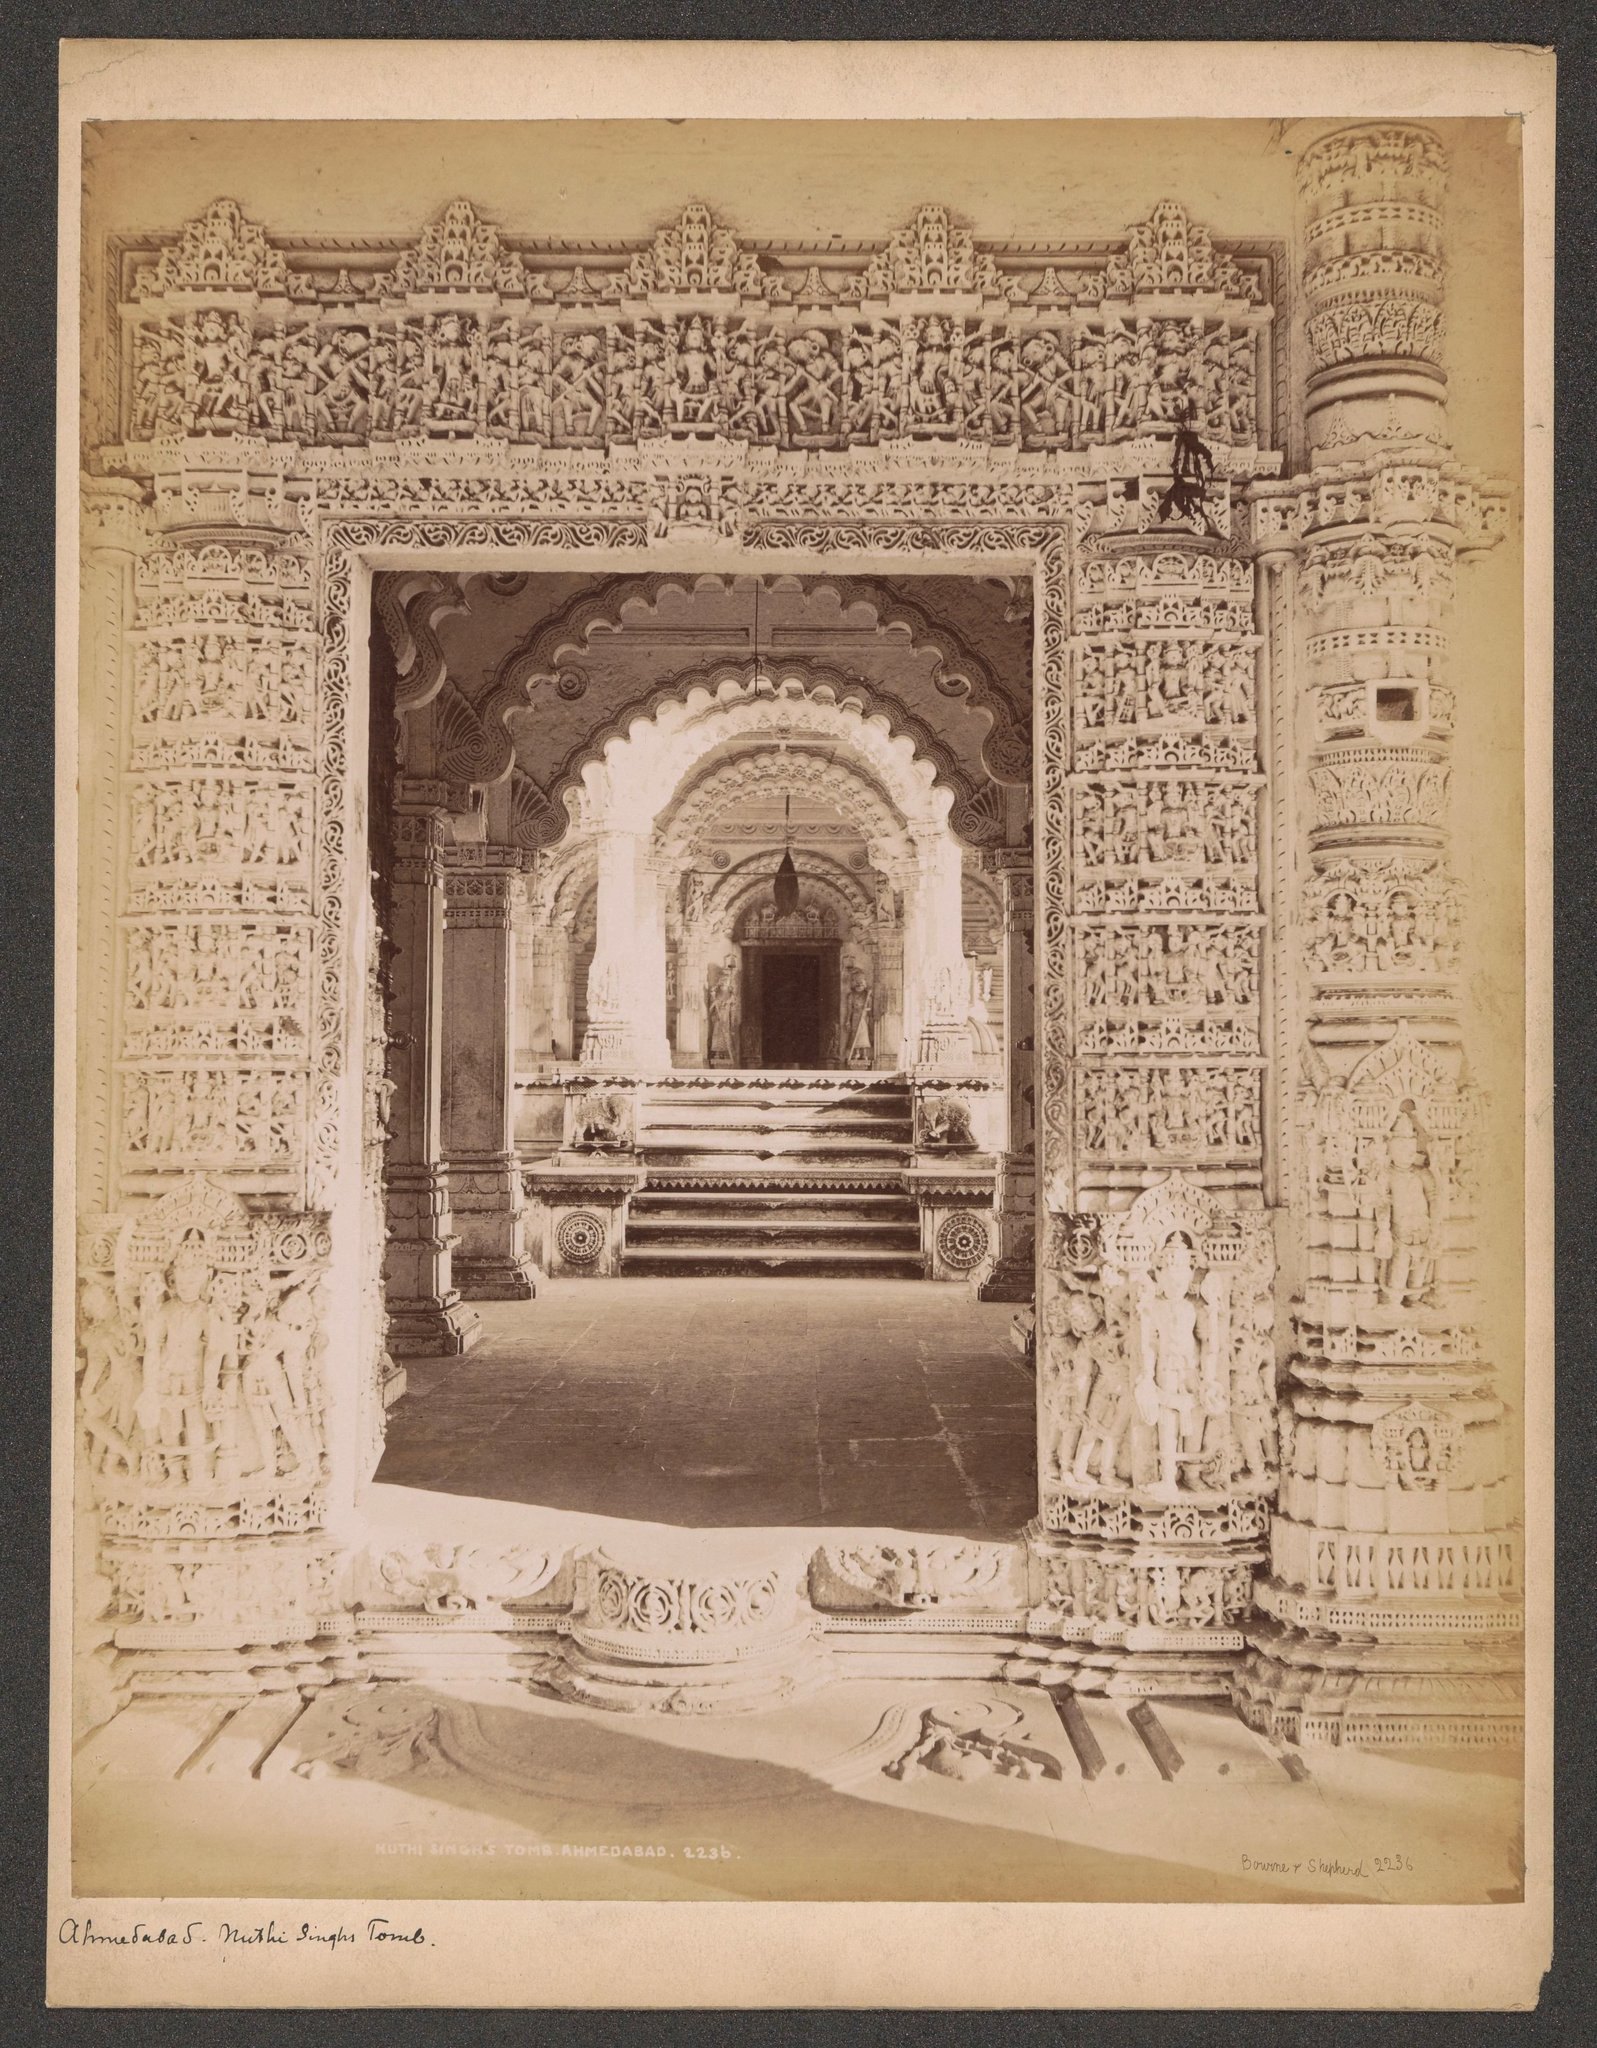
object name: photograph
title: Gallery in the Hutheesing temple in Ahmedabad, Gujarat, India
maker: colin murray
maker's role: fotograaf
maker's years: 1840-1884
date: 1872-1873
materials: cardboard, paper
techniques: albumen print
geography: ahmedabad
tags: temple, shrine ~ hinduism, buddhism, jainism, gallery (spacious corridor)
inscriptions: inscription: ‘Ahmedabad. Huthi Singhs Tomb.’, number: ‘2236/ 2236’, title: ‘Huthi Singh's Tomb. Ahmedabad.’